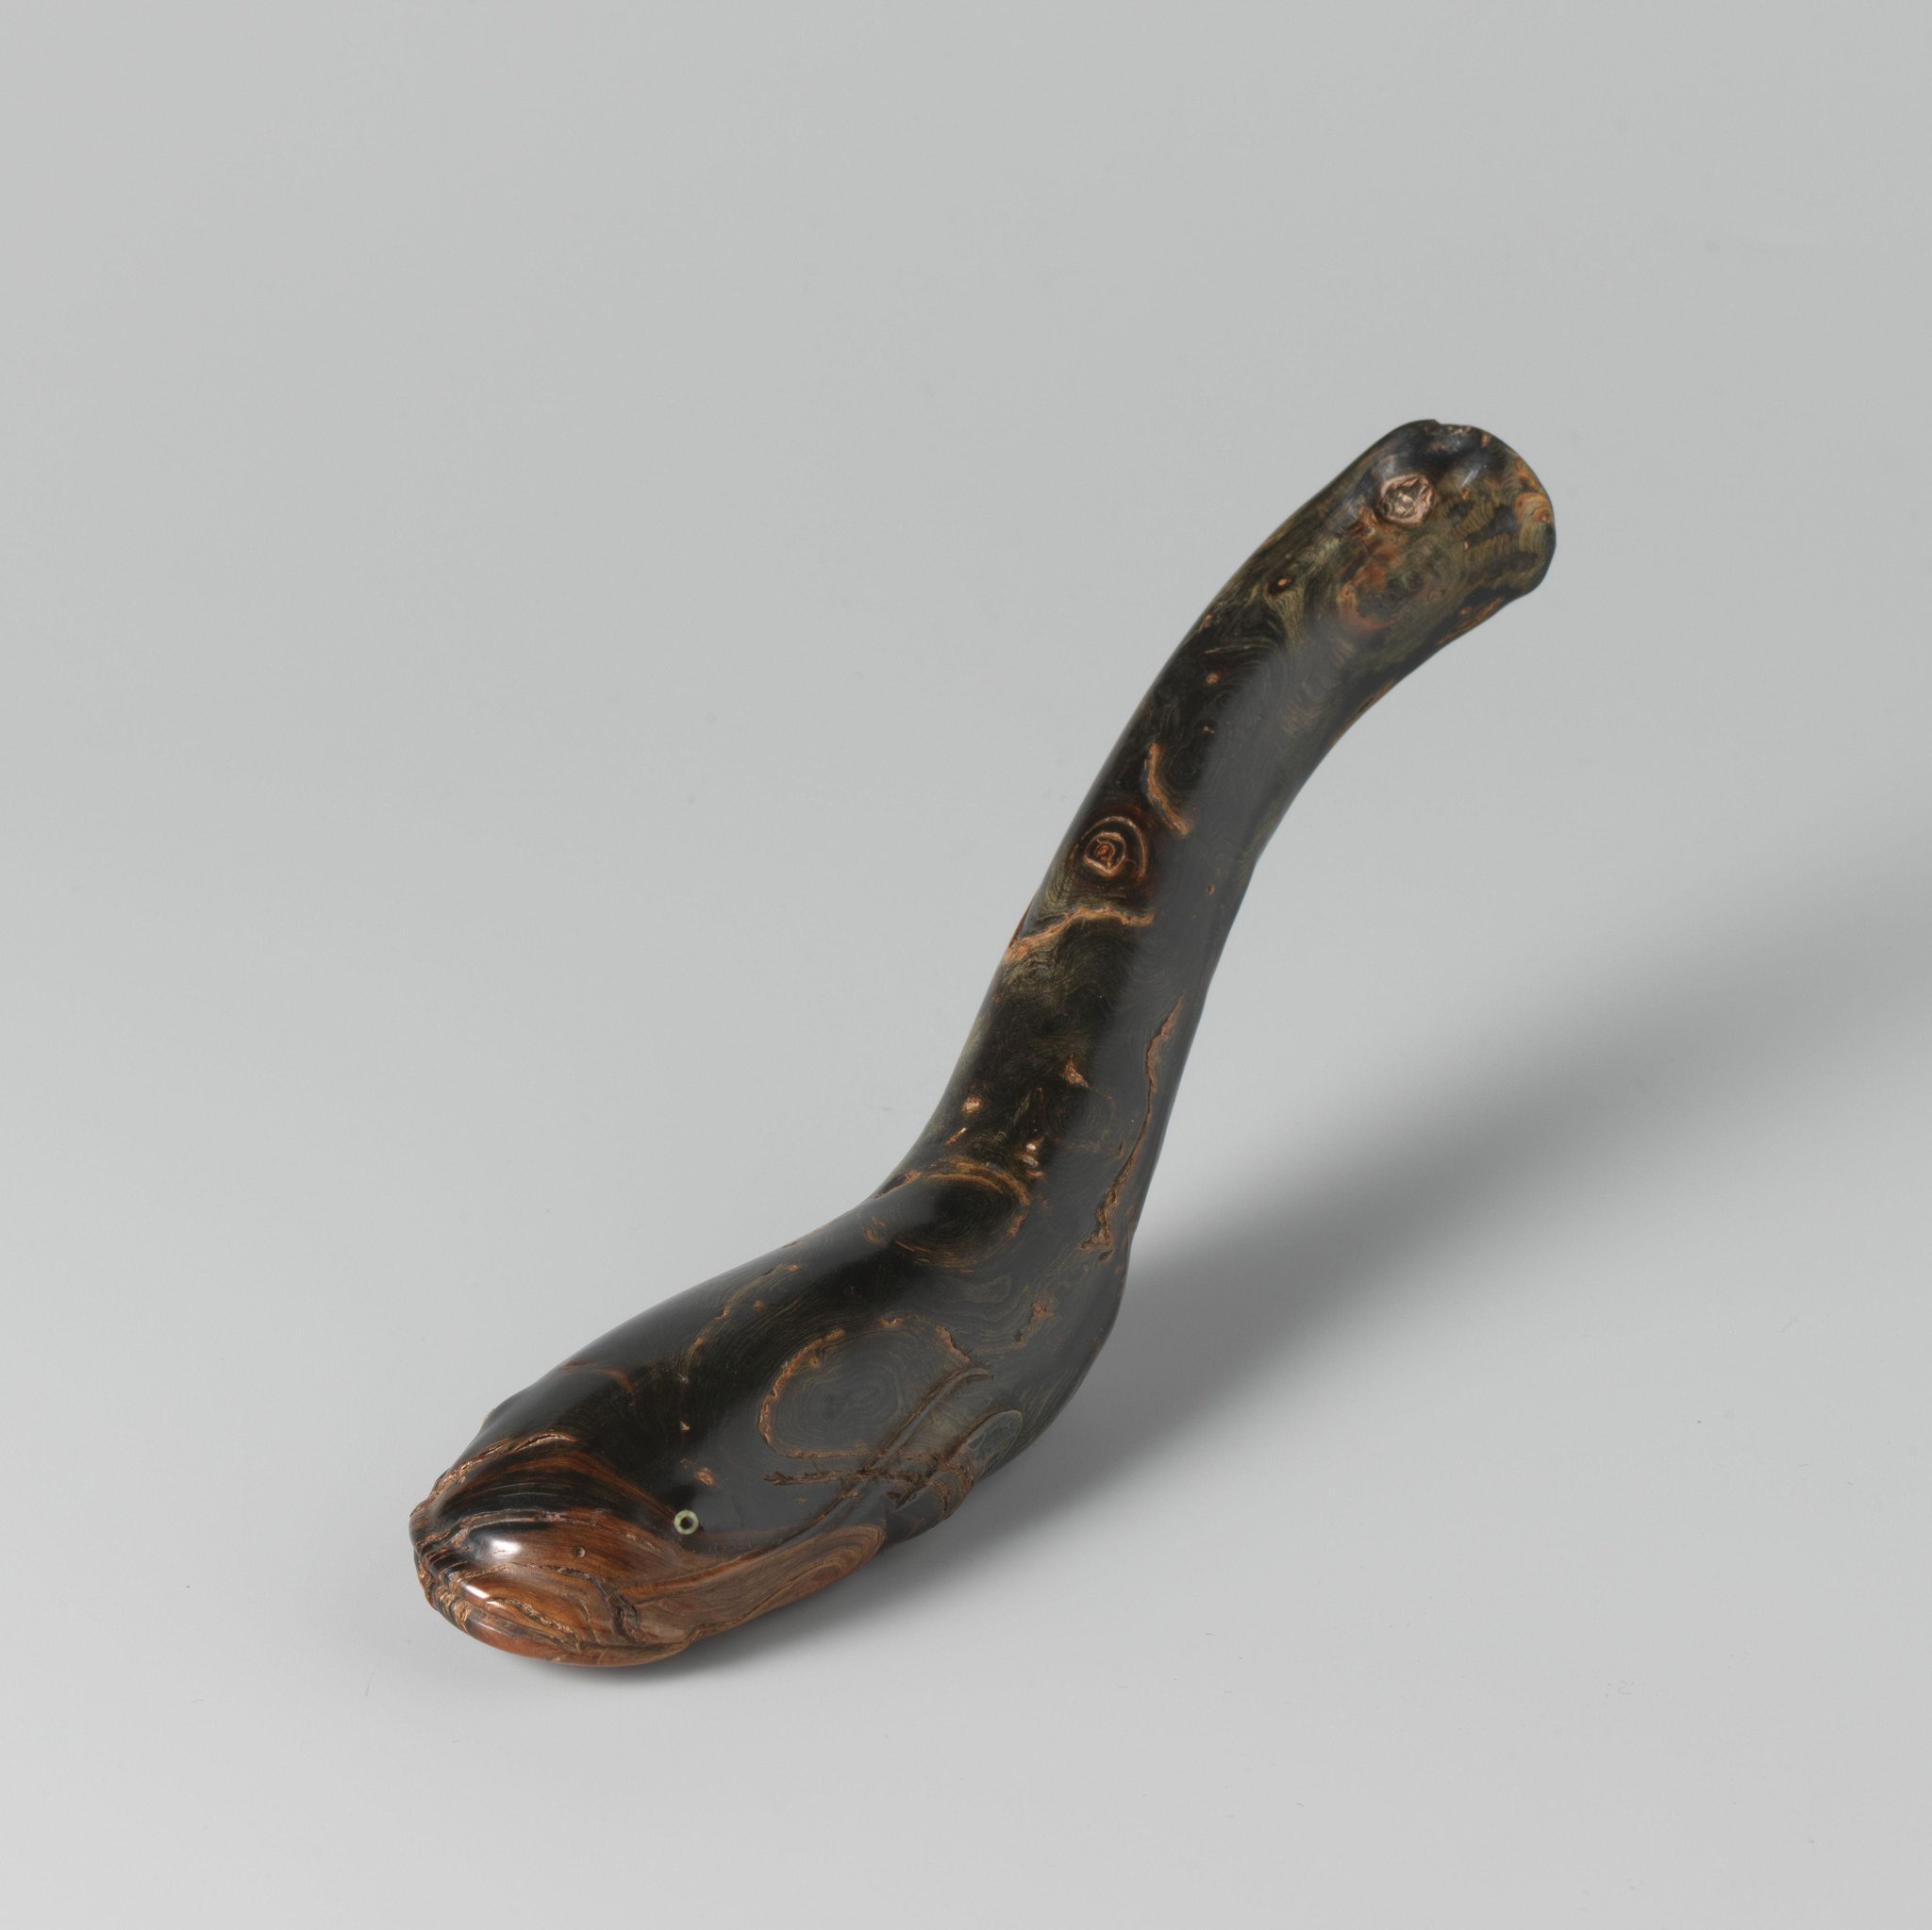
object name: sculpture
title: Earthquake Fish (Namazu)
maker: Anonymous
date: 1600-1868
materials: umimatsu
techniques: material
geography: japan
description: The dangers inherent in Japanese nature are also reflected in art. These objects are often designed with gentle humour. This catfish represents the namazu: a mythical fish that, according to legend, lies under the islands of Japan and causes earthquakes.